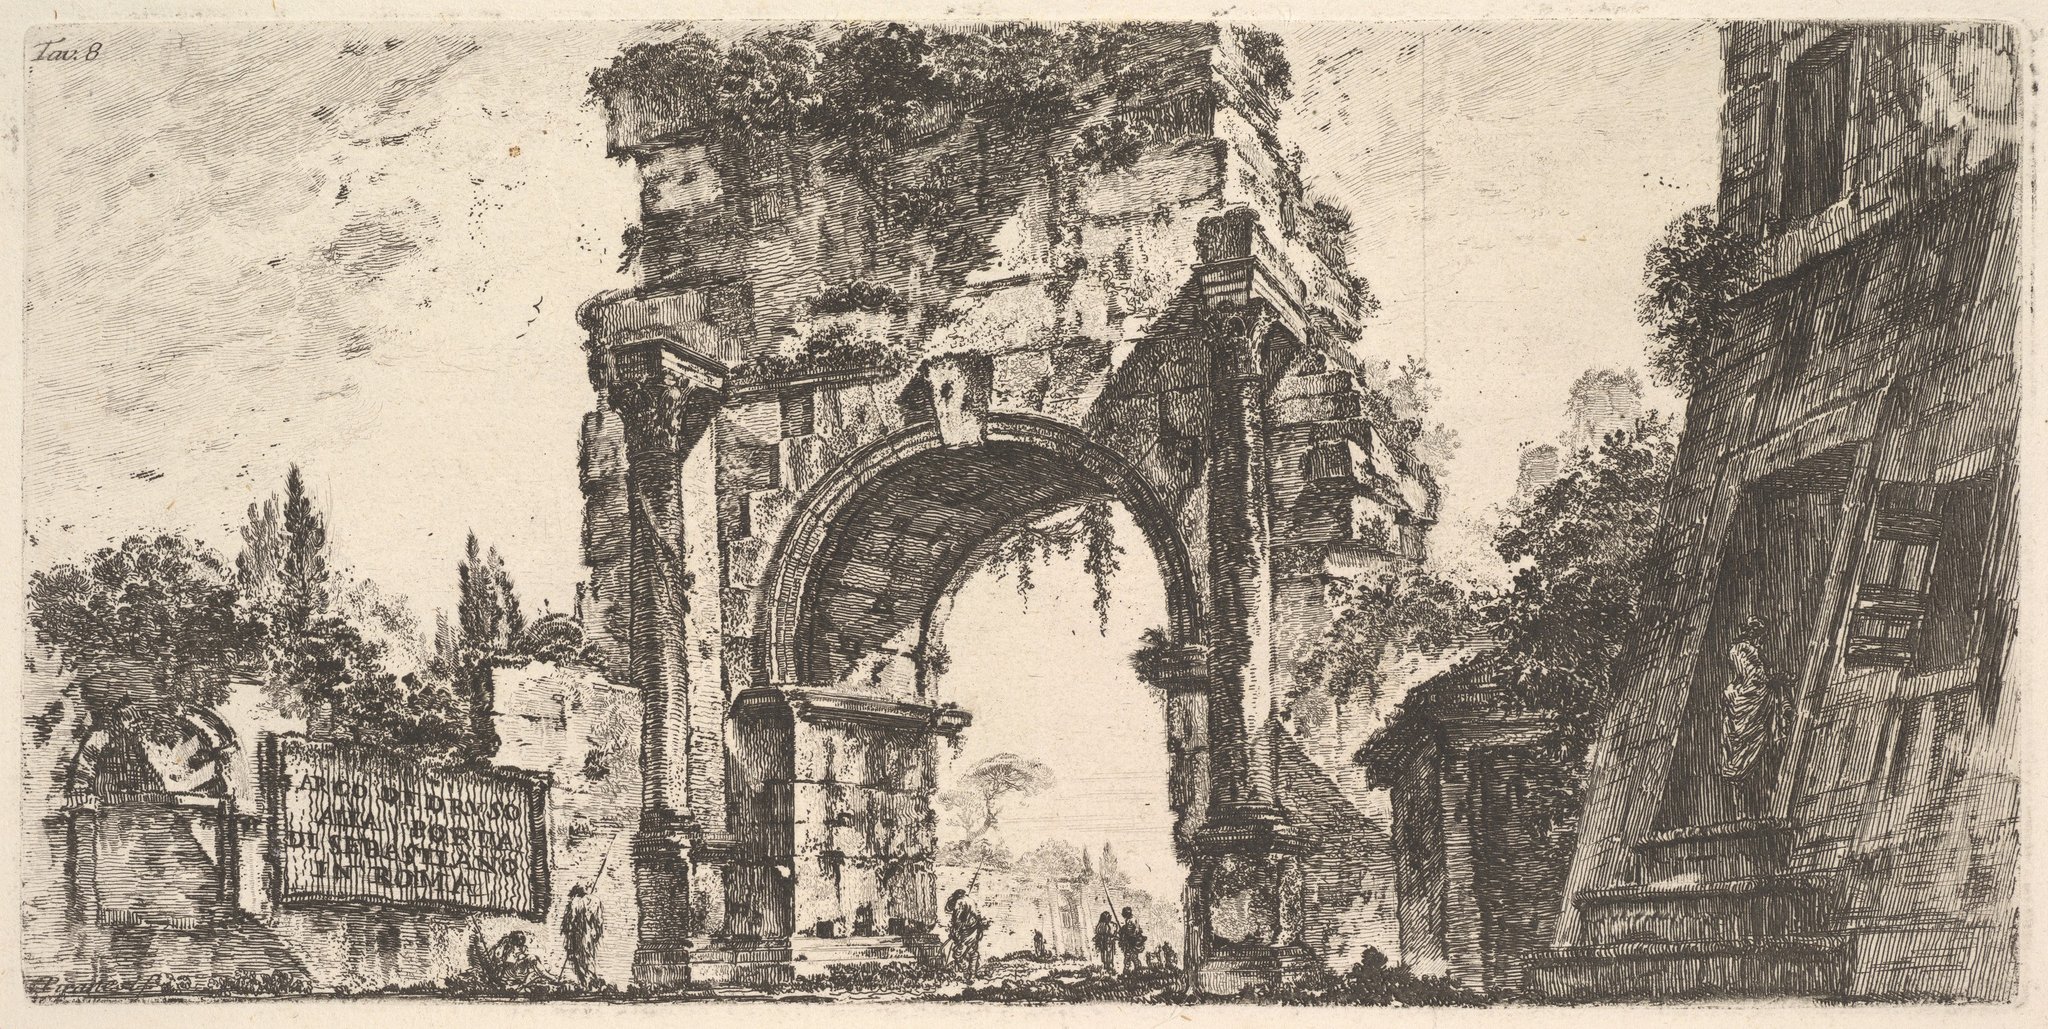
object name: print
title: Plate 8: Arch of Drusus at the Porta S. Sebastiano in Rome (Arco di Druso alla Porta di Sebastiano in Roma), from "Antichità Romane de' Tempi della Repubblica, e de' primi Imperatori"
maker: giovanni battista piranesi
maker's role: artist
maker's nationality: italian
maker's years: 1720-1778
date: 1748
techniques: etching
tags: arches,ruins,rome